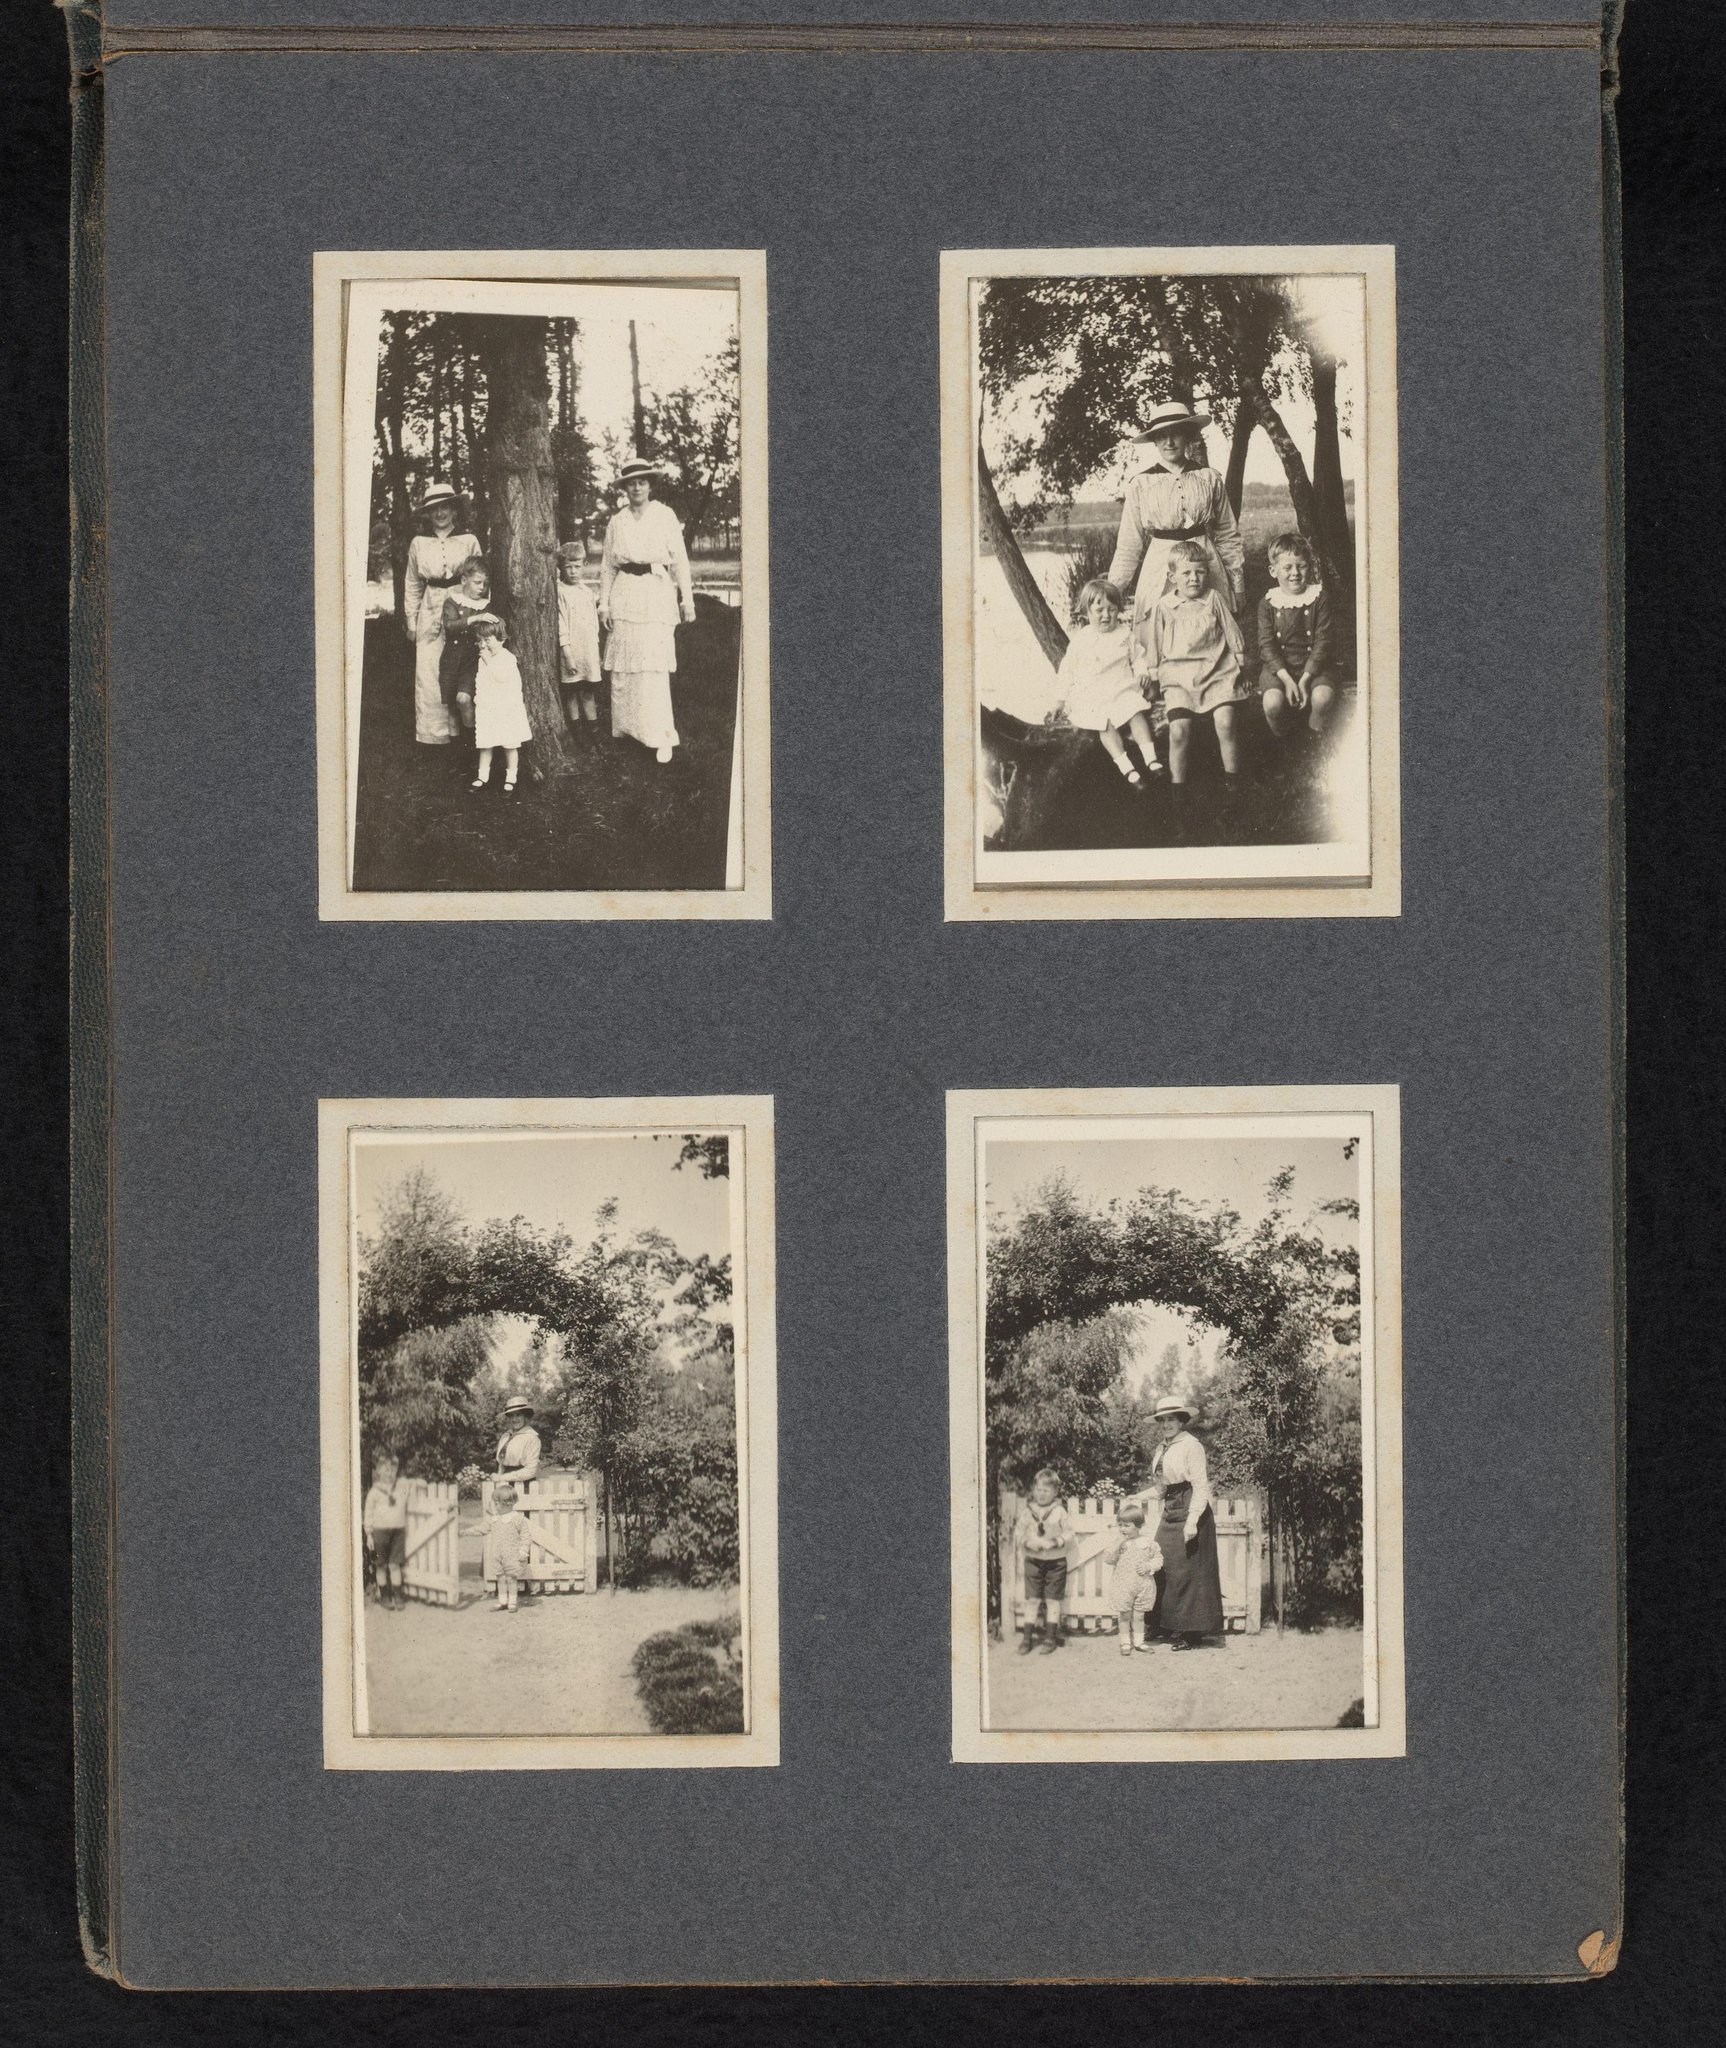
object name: photograph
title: Twee vrouwen en drie kinderen van de familie van den Berg in een tuin in Bergerac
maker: hendrik herman van den berg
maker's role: amateurfotograaf, jurist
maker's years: 1875-1944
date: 1907-1915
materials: paper, cardboard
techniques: gelatin silver print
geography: bergerac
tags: family life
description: Deze foto's zijn onderdeel van een album.